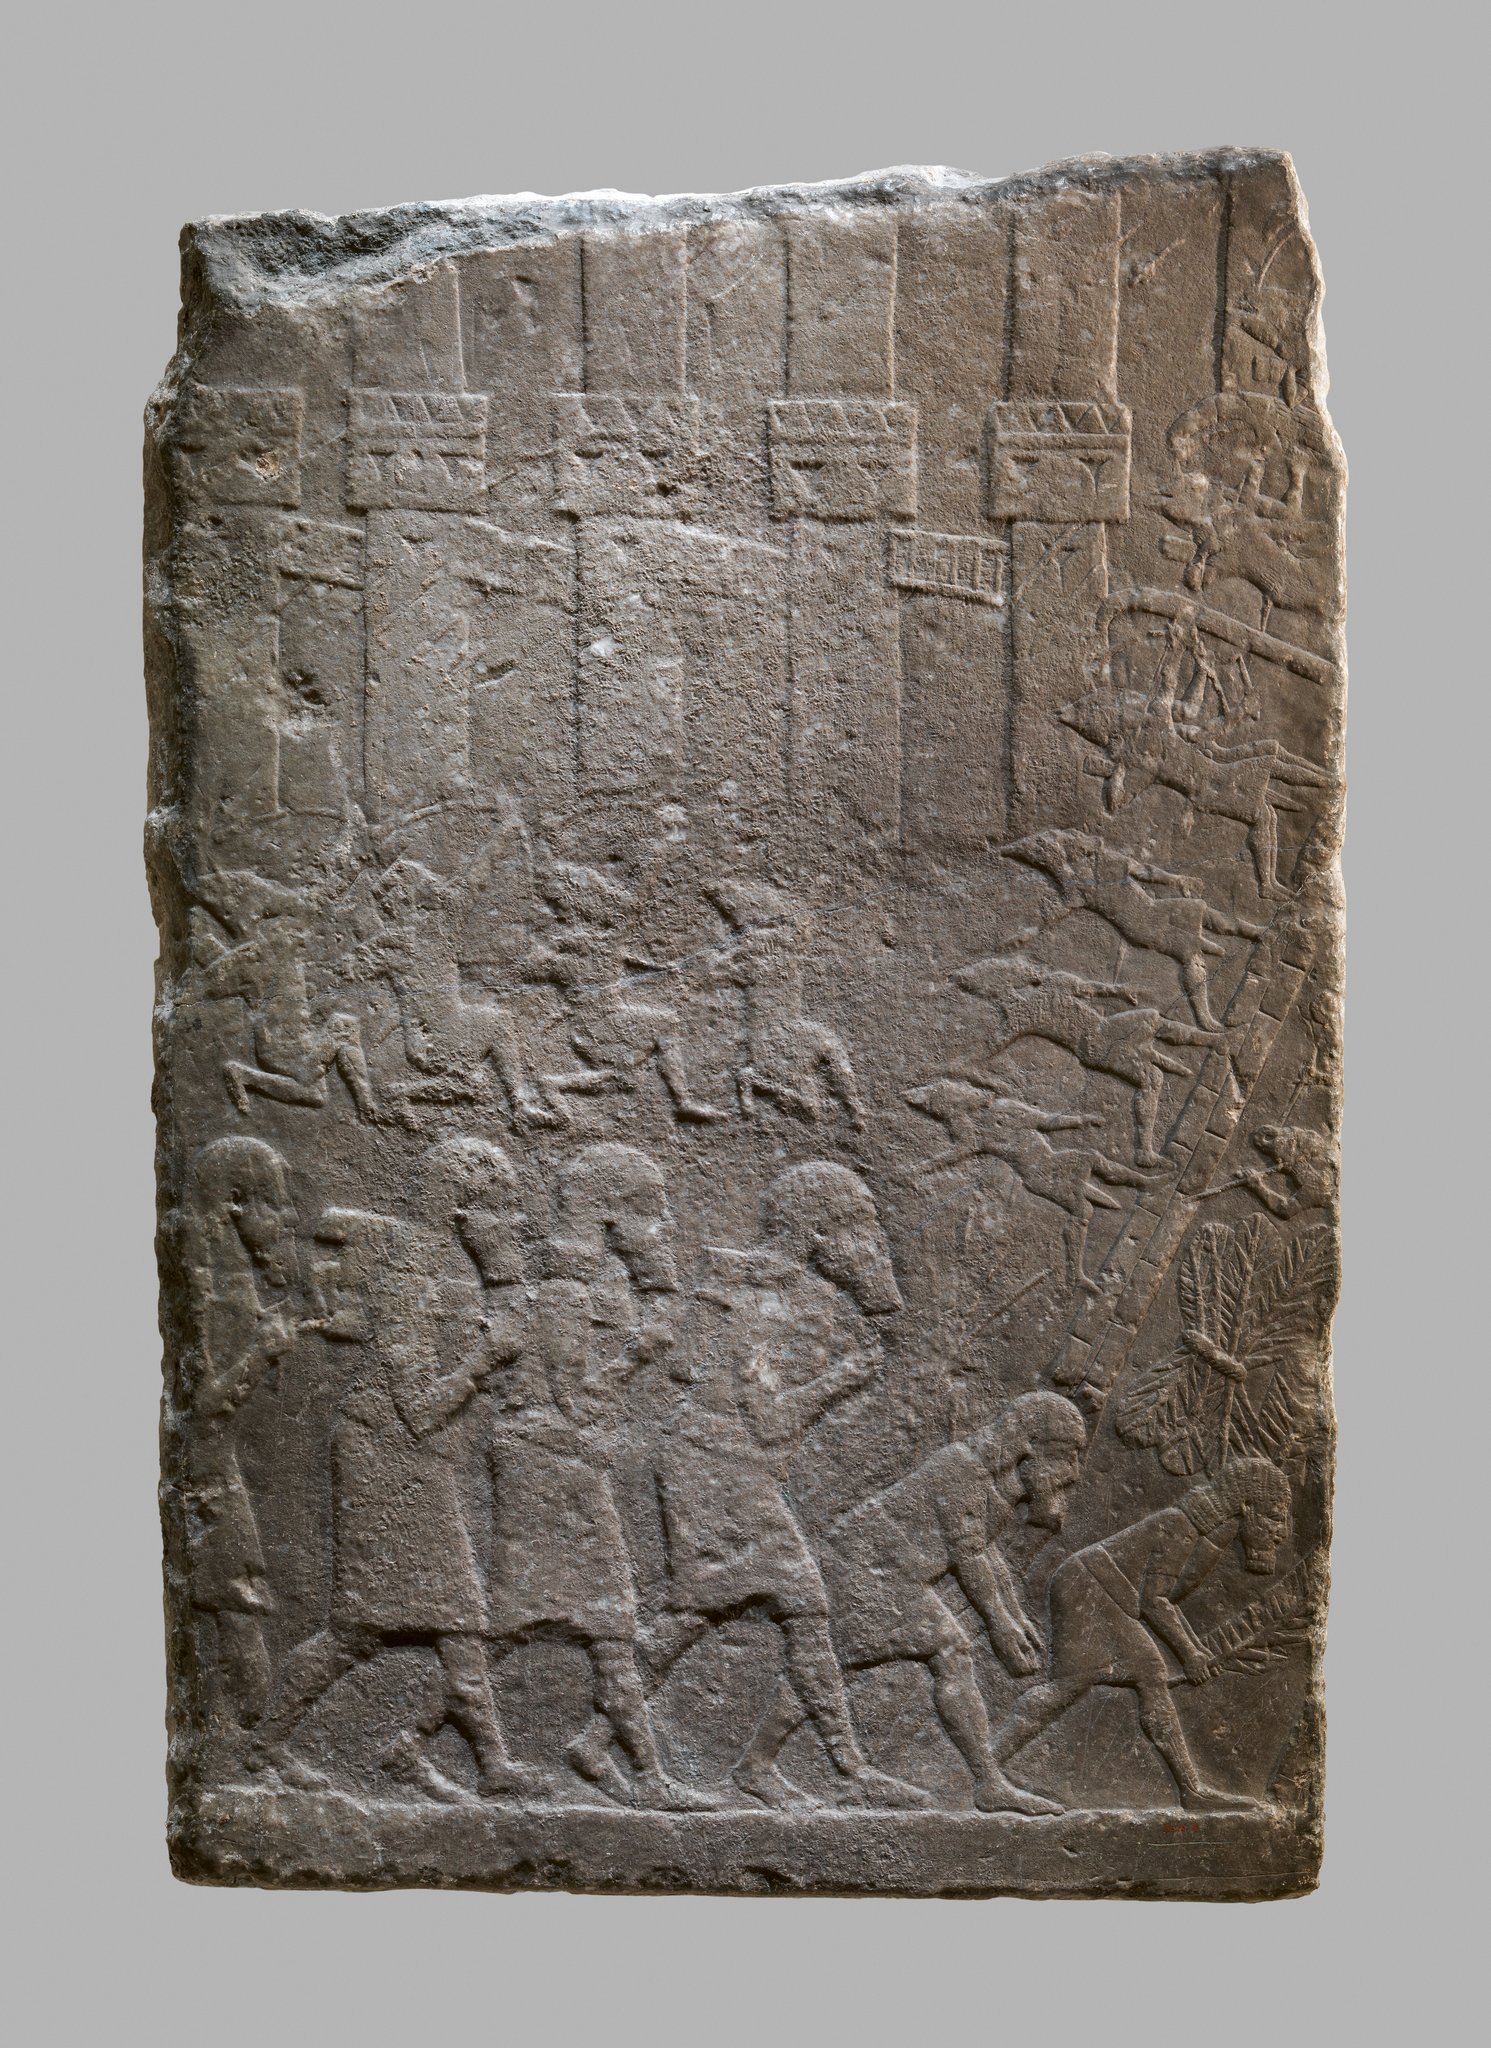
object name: relief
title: Battle scene of Assyrians storming a citadel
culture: assyrian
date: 704-681 BCE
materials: alabaster, gypsum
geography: mesopotamia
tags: battles,bow and arrow,men